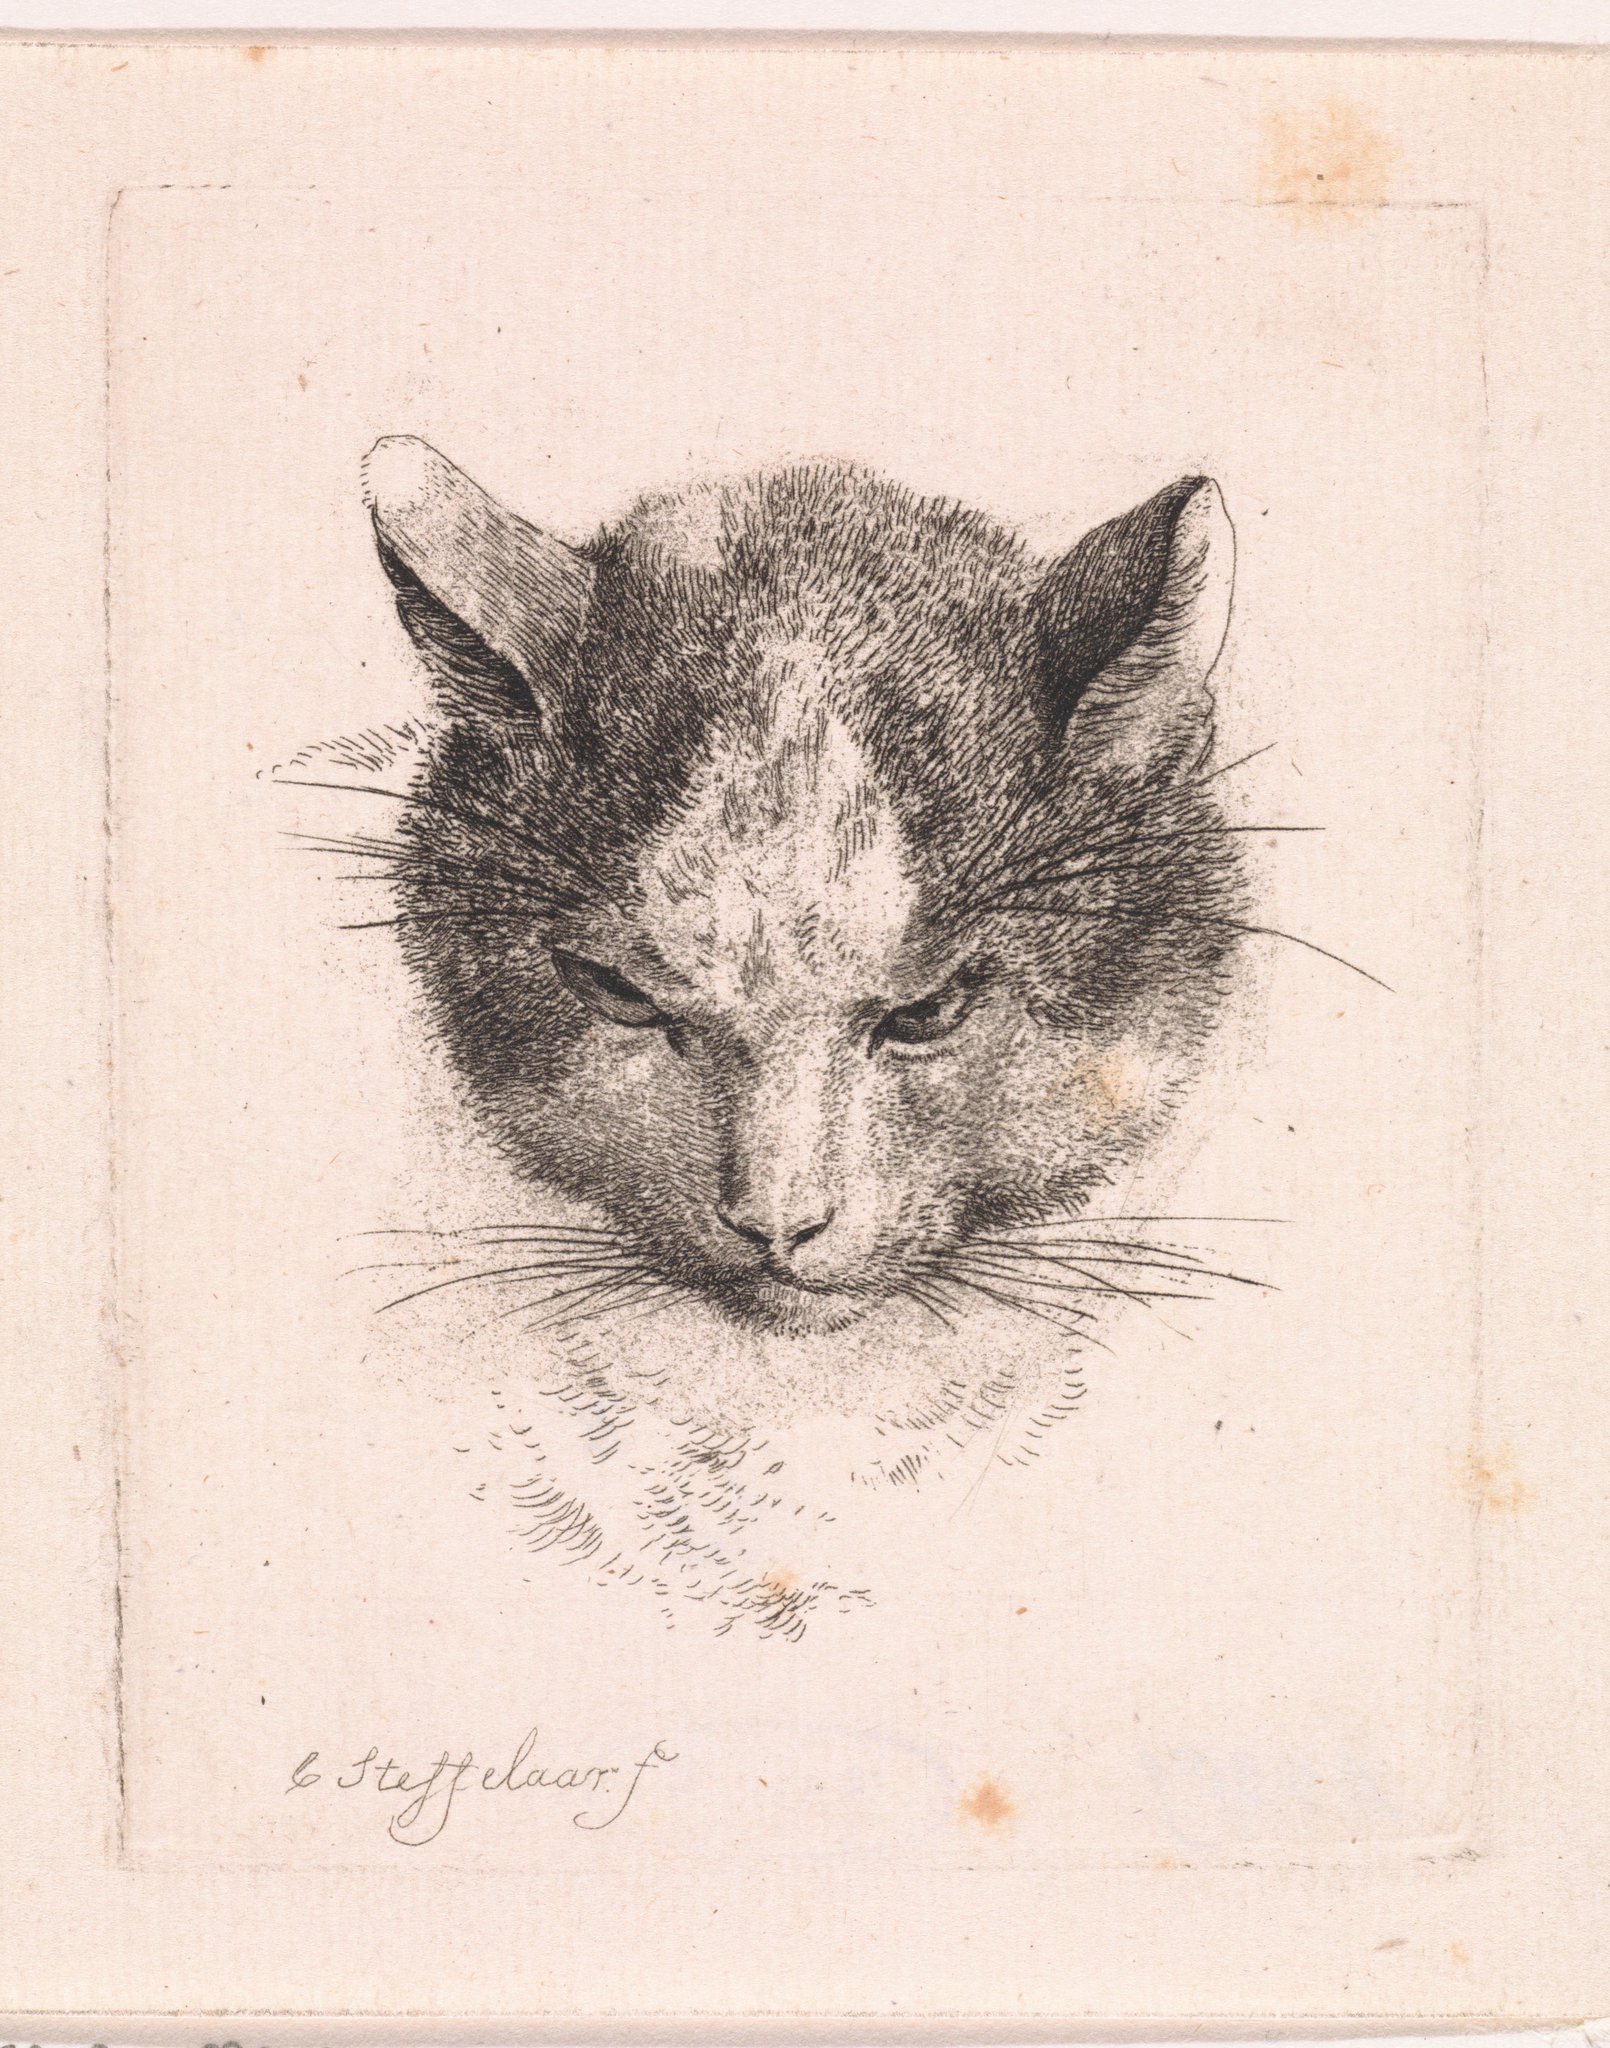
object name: print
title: Eerste suite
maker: cornelis steffelaar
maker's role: draughtsman, painter, print maker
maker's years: 1797-1861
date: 1807-1861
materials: paper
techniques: aquatint, etching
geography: amsterdam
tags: cat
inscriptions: collector's mark: Lugt 2228